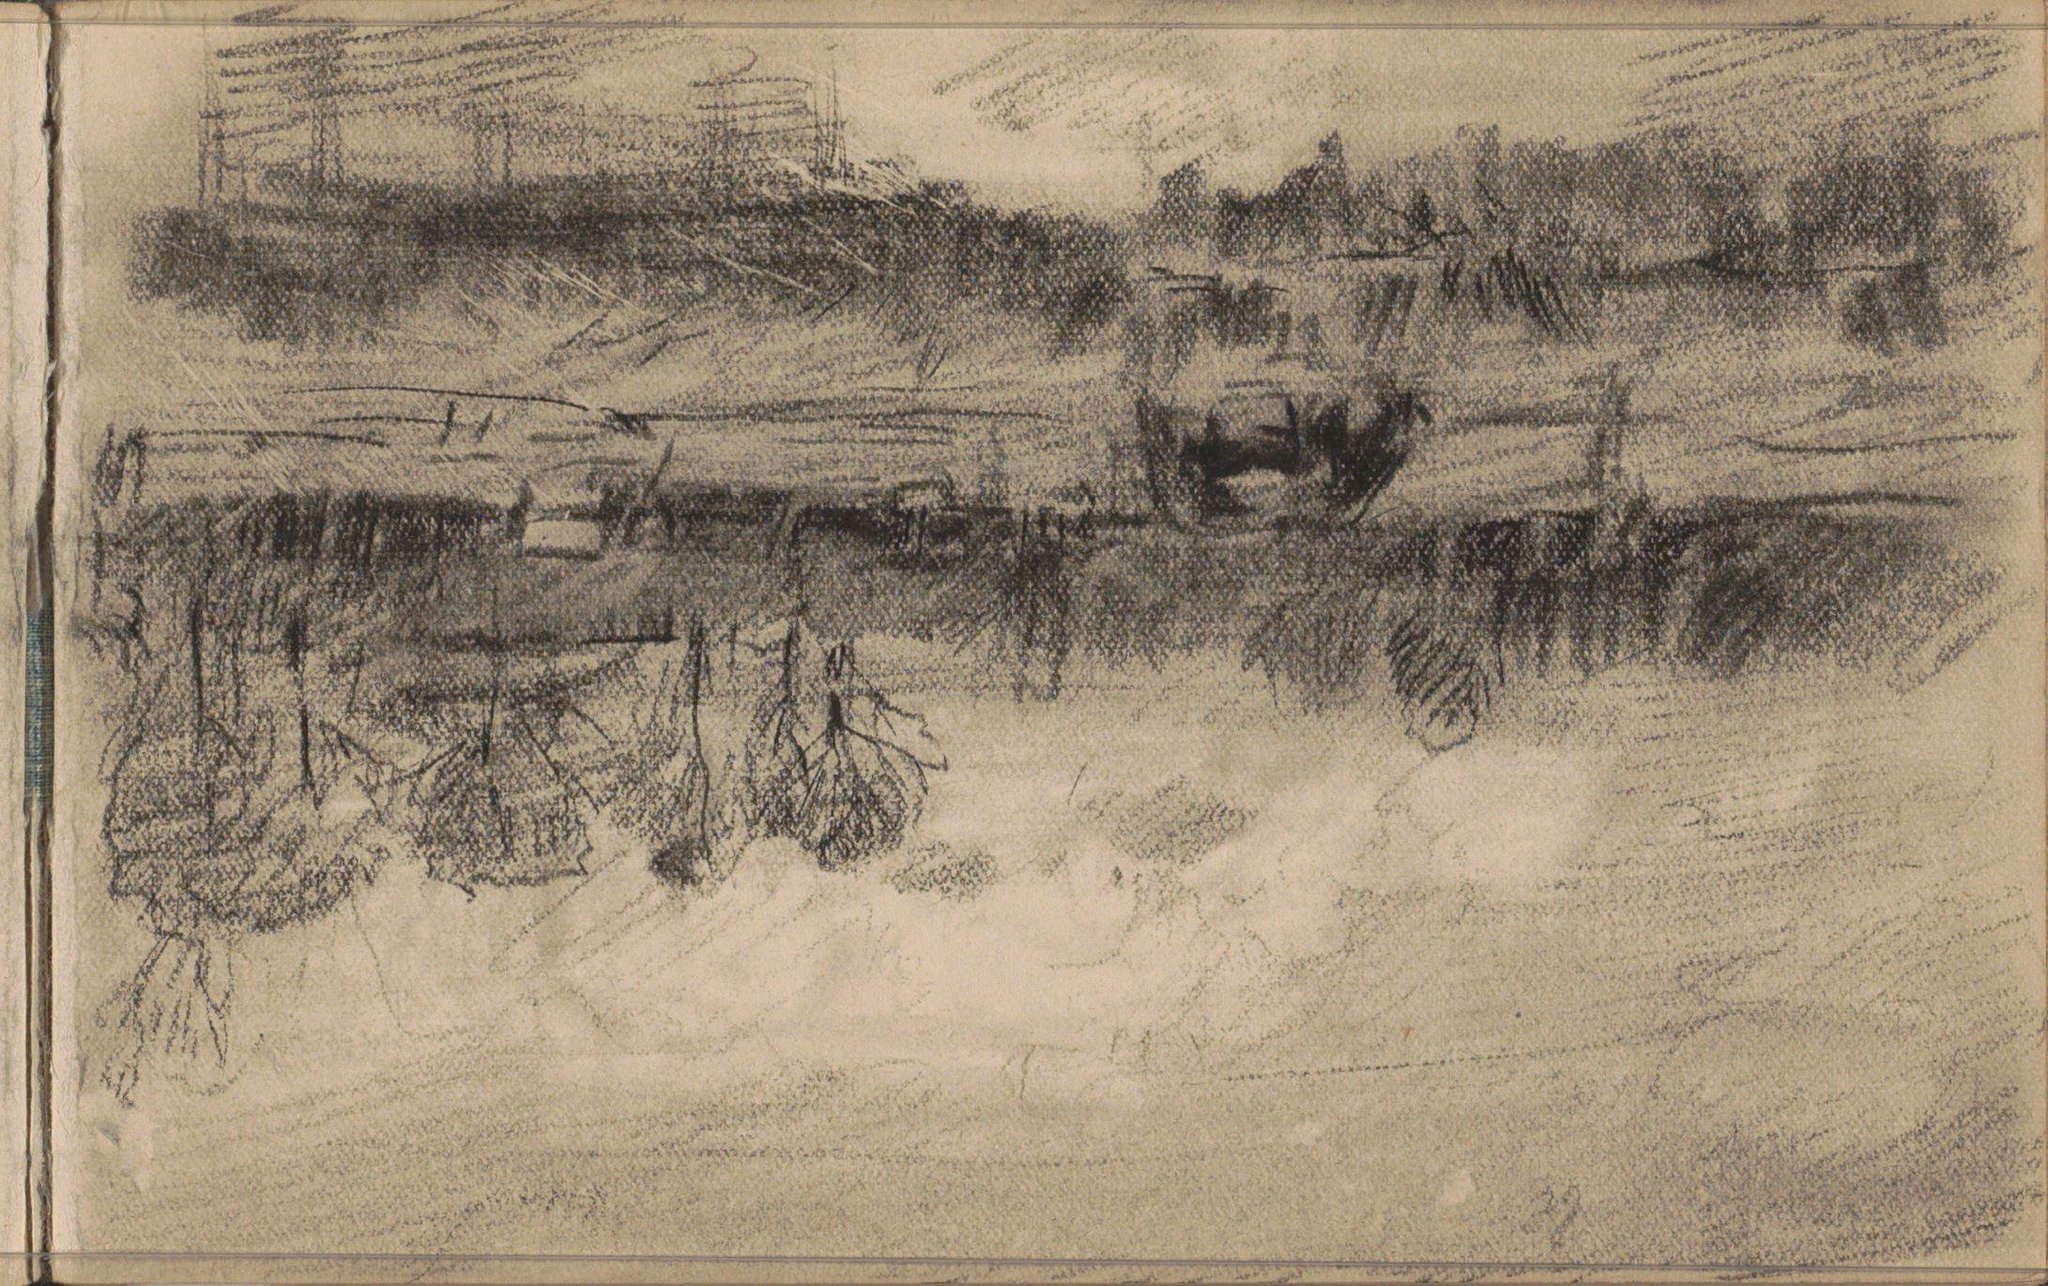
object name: sketchbook leaf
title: Paard of koe in een landschap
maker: johan antonie de jonge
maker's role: draughtsman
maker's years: 1864-1927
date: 1909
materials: chalk, paper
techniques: stumping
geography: south holland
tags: cow, horse, farm or solitary house in landscape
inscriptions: kleurnotitie, handgeschreven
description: Paard of koe in een landschap. Blad 10 uit een schetsboek met 31 bladen.